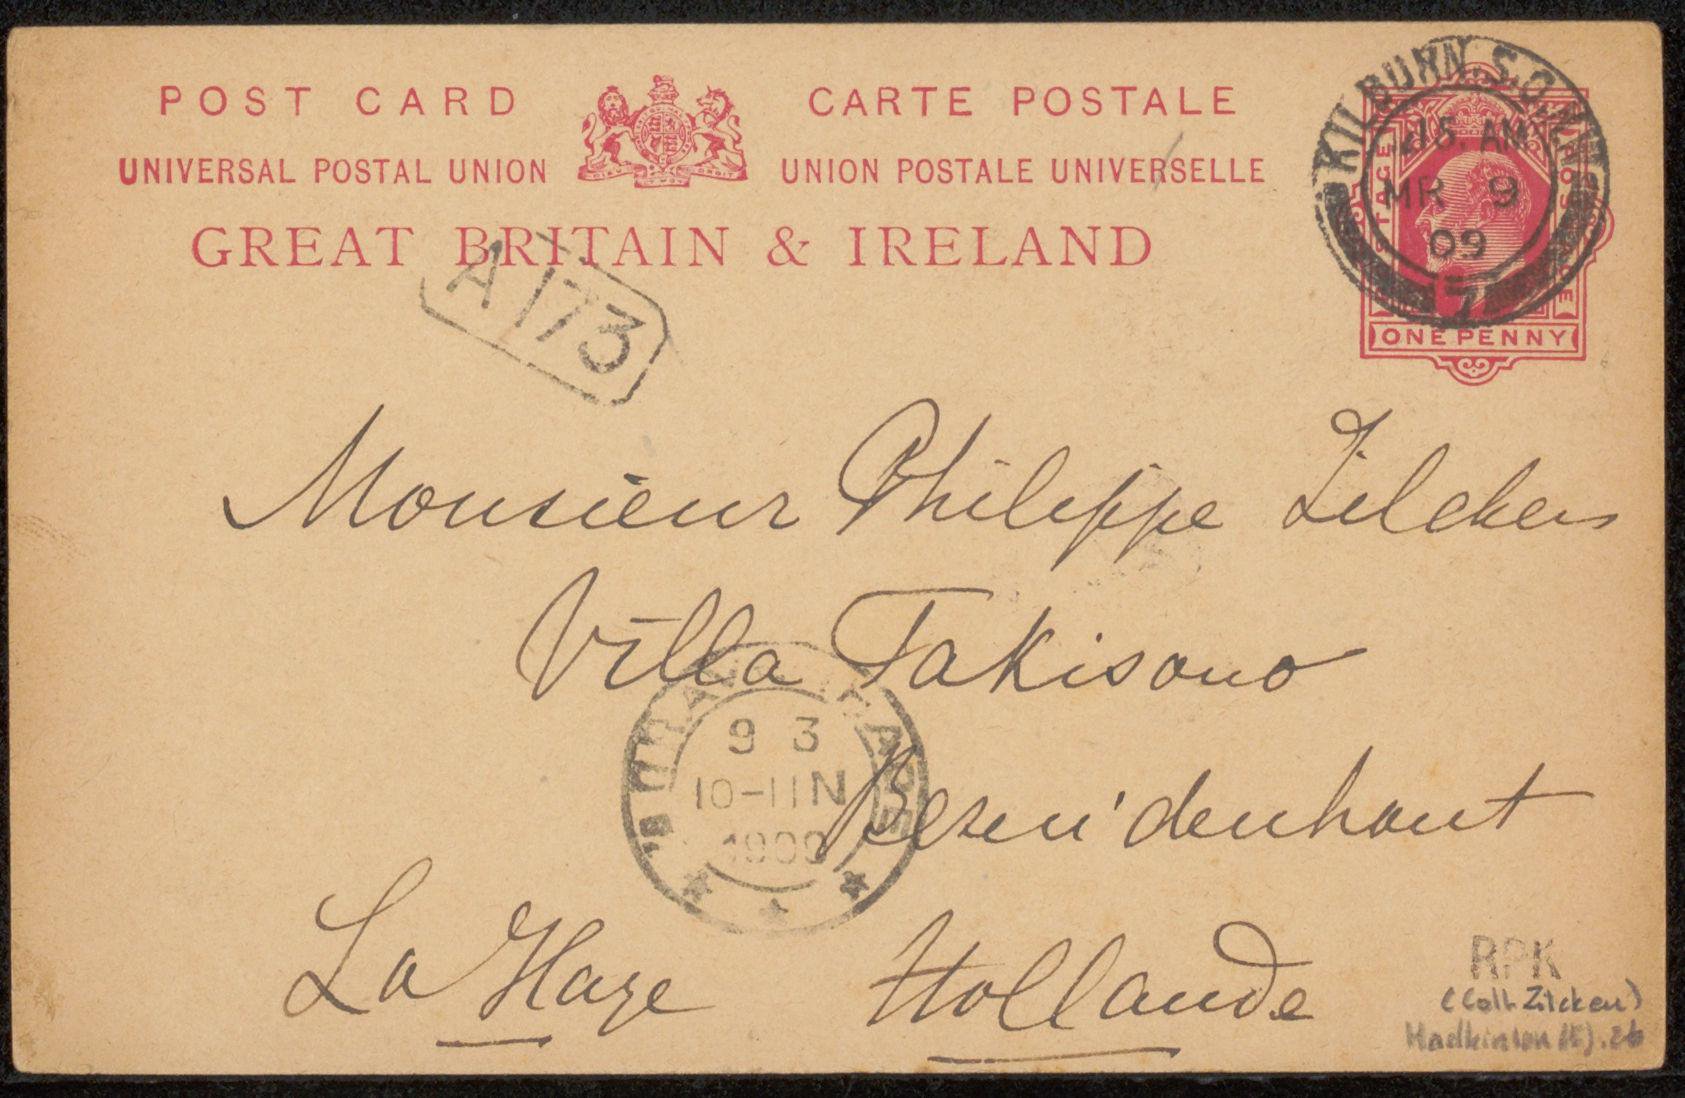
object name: postcard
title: Briefkaart aan Philip Zilcken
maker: ernestine hadkinson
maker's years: 1863-1928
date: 1909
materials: cardboard, ink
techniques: pen, writing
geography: hampstead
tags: the hague, painter, draughtsman, philip zilcken, exhibition ~ art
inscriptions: collector's mark: ‘RPK’